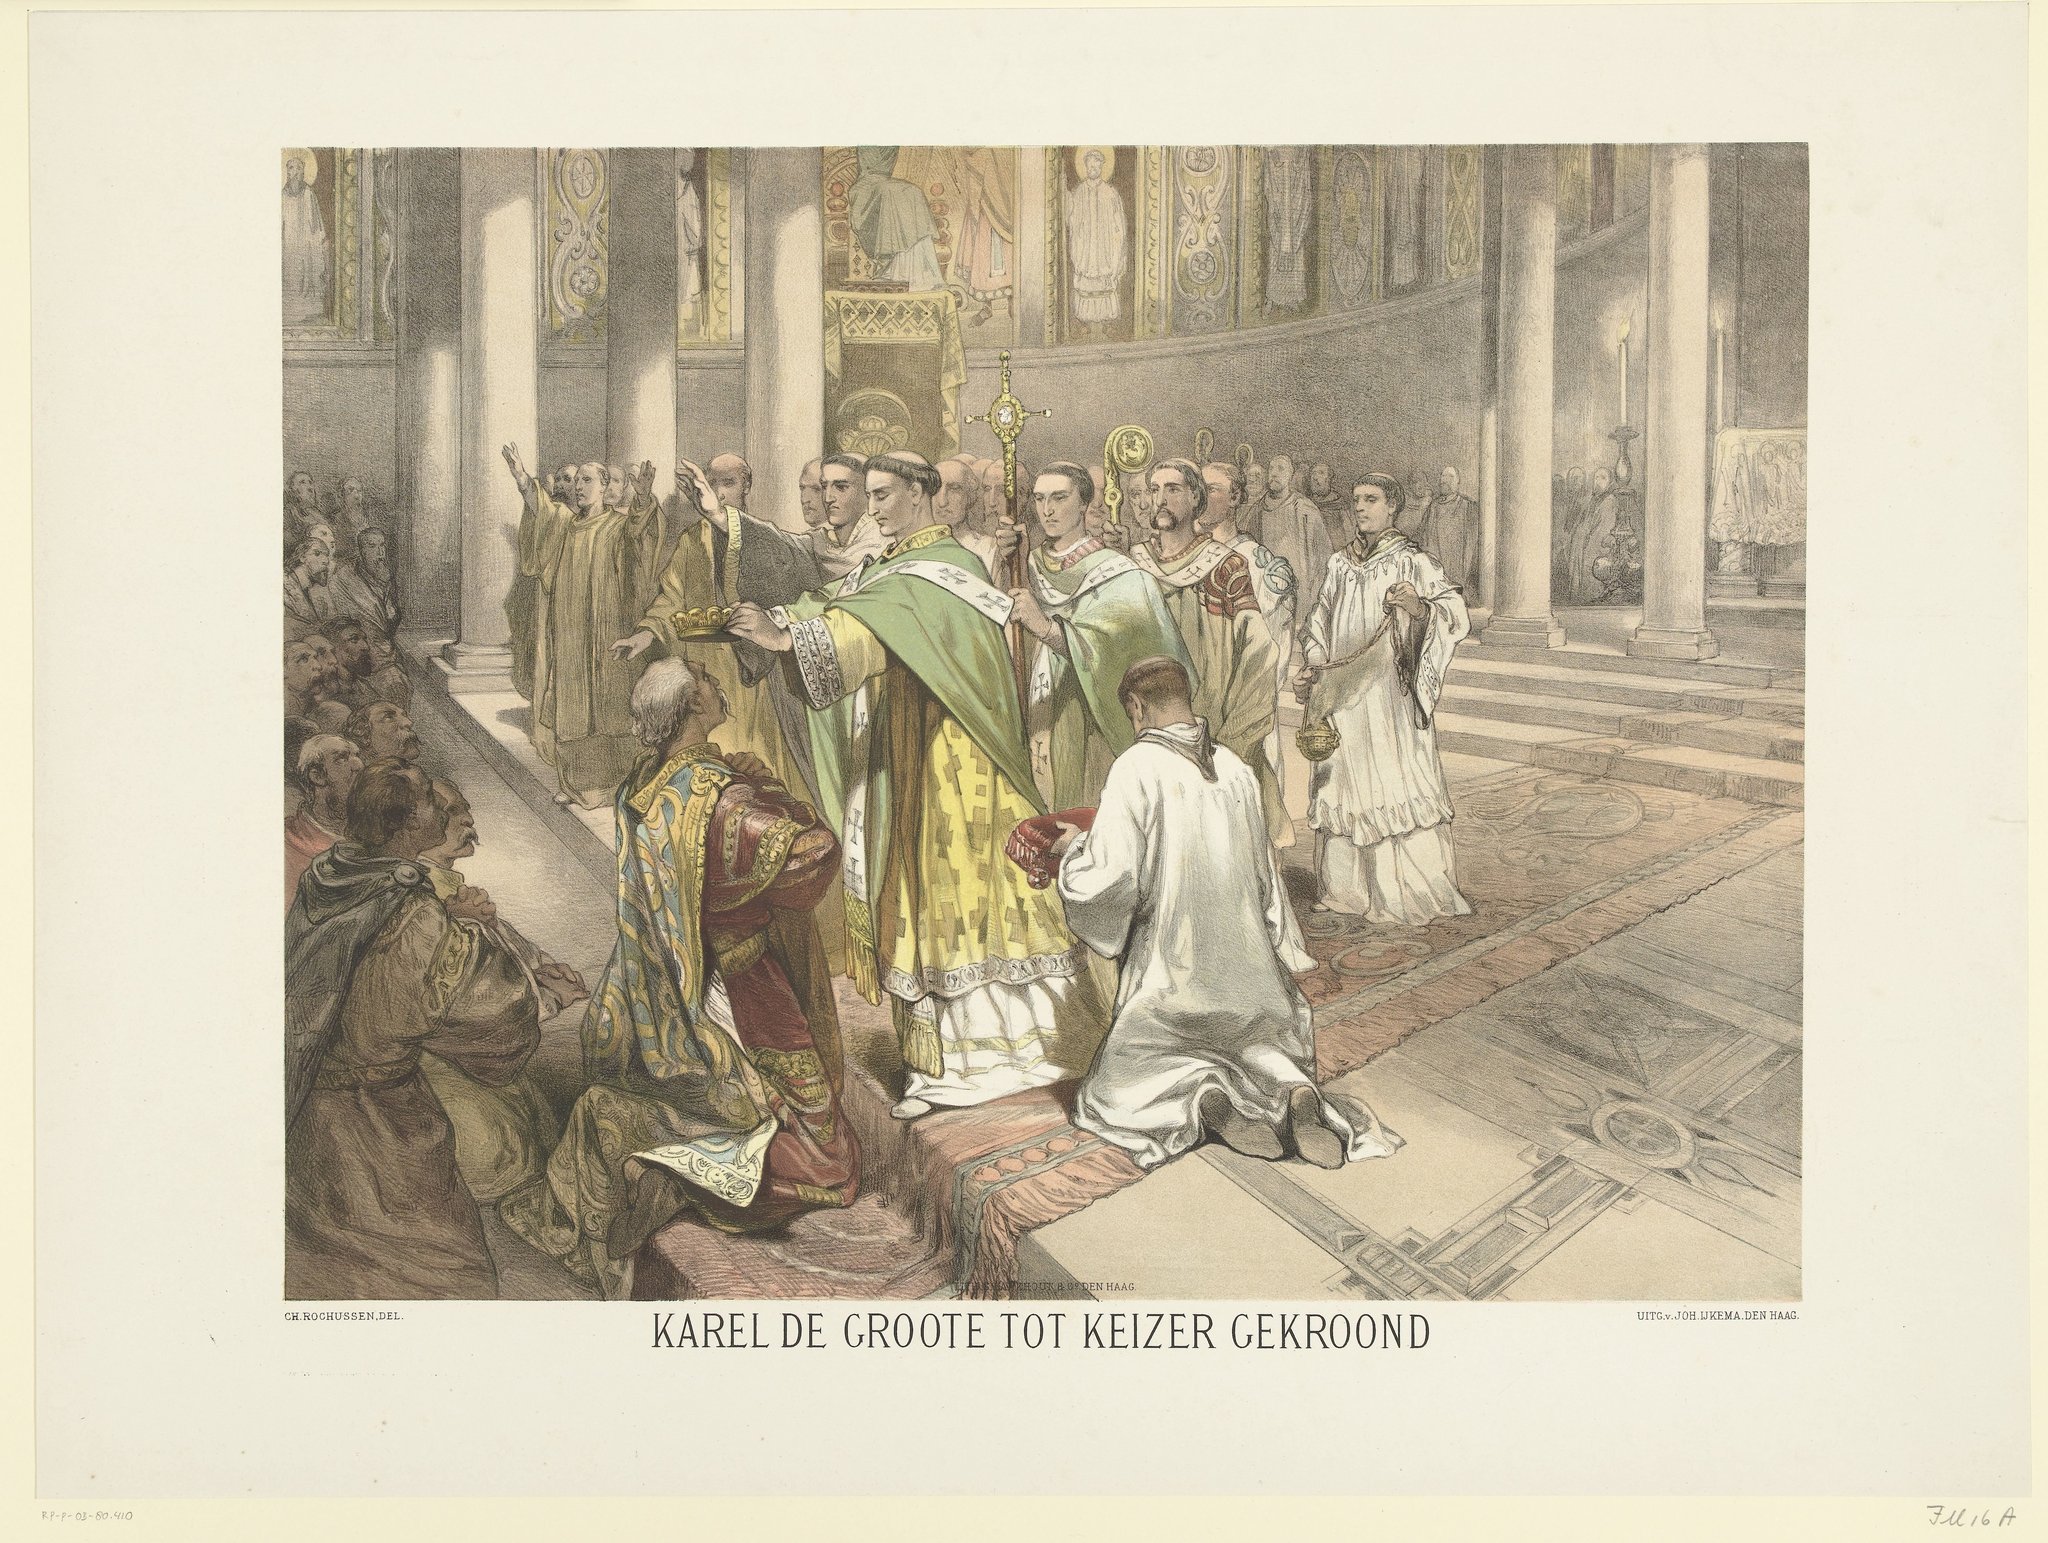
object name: history print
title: Karel de Groote tot keizer gekroond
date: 1878-1880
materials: paper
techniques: lithograph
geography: the hague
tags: charlemagne (holy roman emperor), coronation of a ruler, rome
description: Karel de Grote in Rome door paus Leo III tot Romeins keizer gekroond, 25 december 800. Een roomse geestelijke houdt de kroon boven het hoofd van de knielende Karel de Grote.